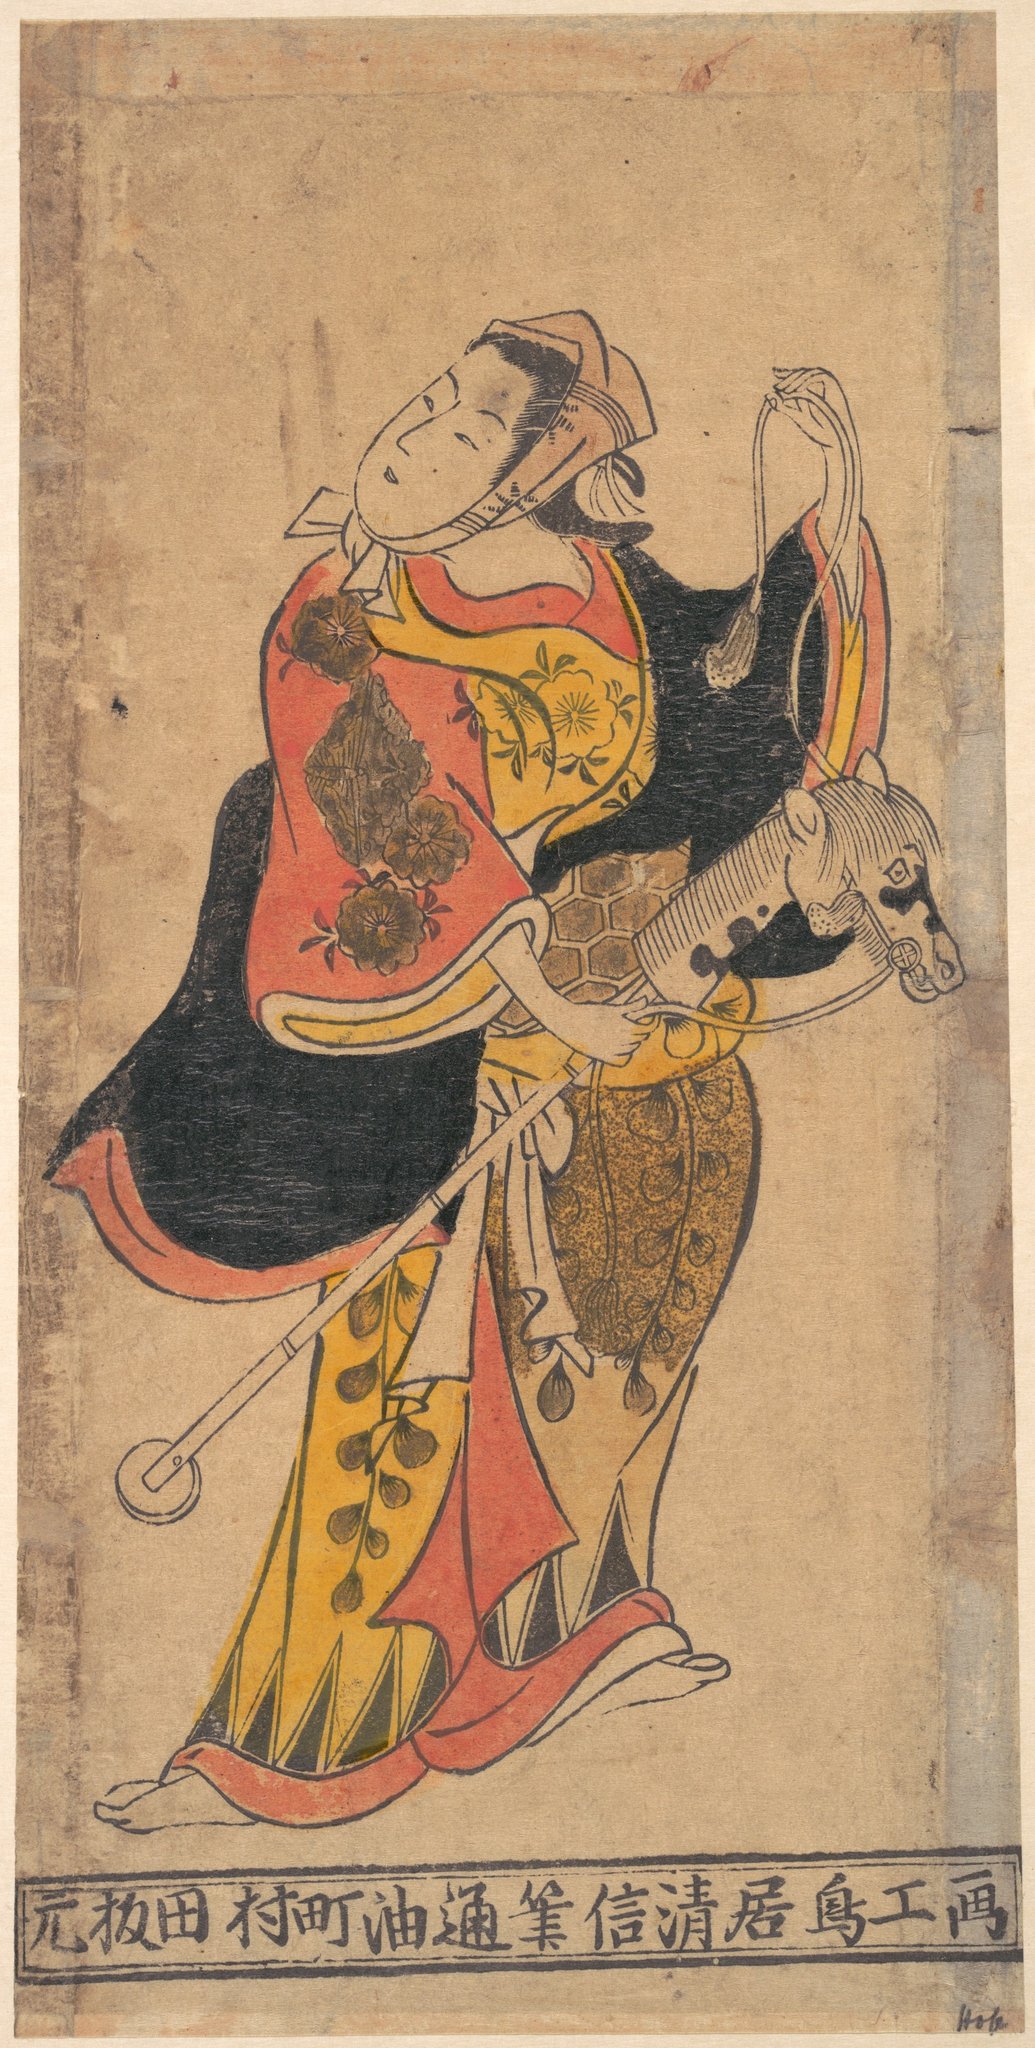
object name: woodblock print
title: Actor as Woman with Hobby–horse in Unidentified Role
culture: japanese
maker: torii kiyonobu i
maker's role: artist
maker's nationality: japanese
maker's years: 1664-1729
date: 1664-1729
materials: ink, paper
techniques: woodblock print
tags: men,women,actors